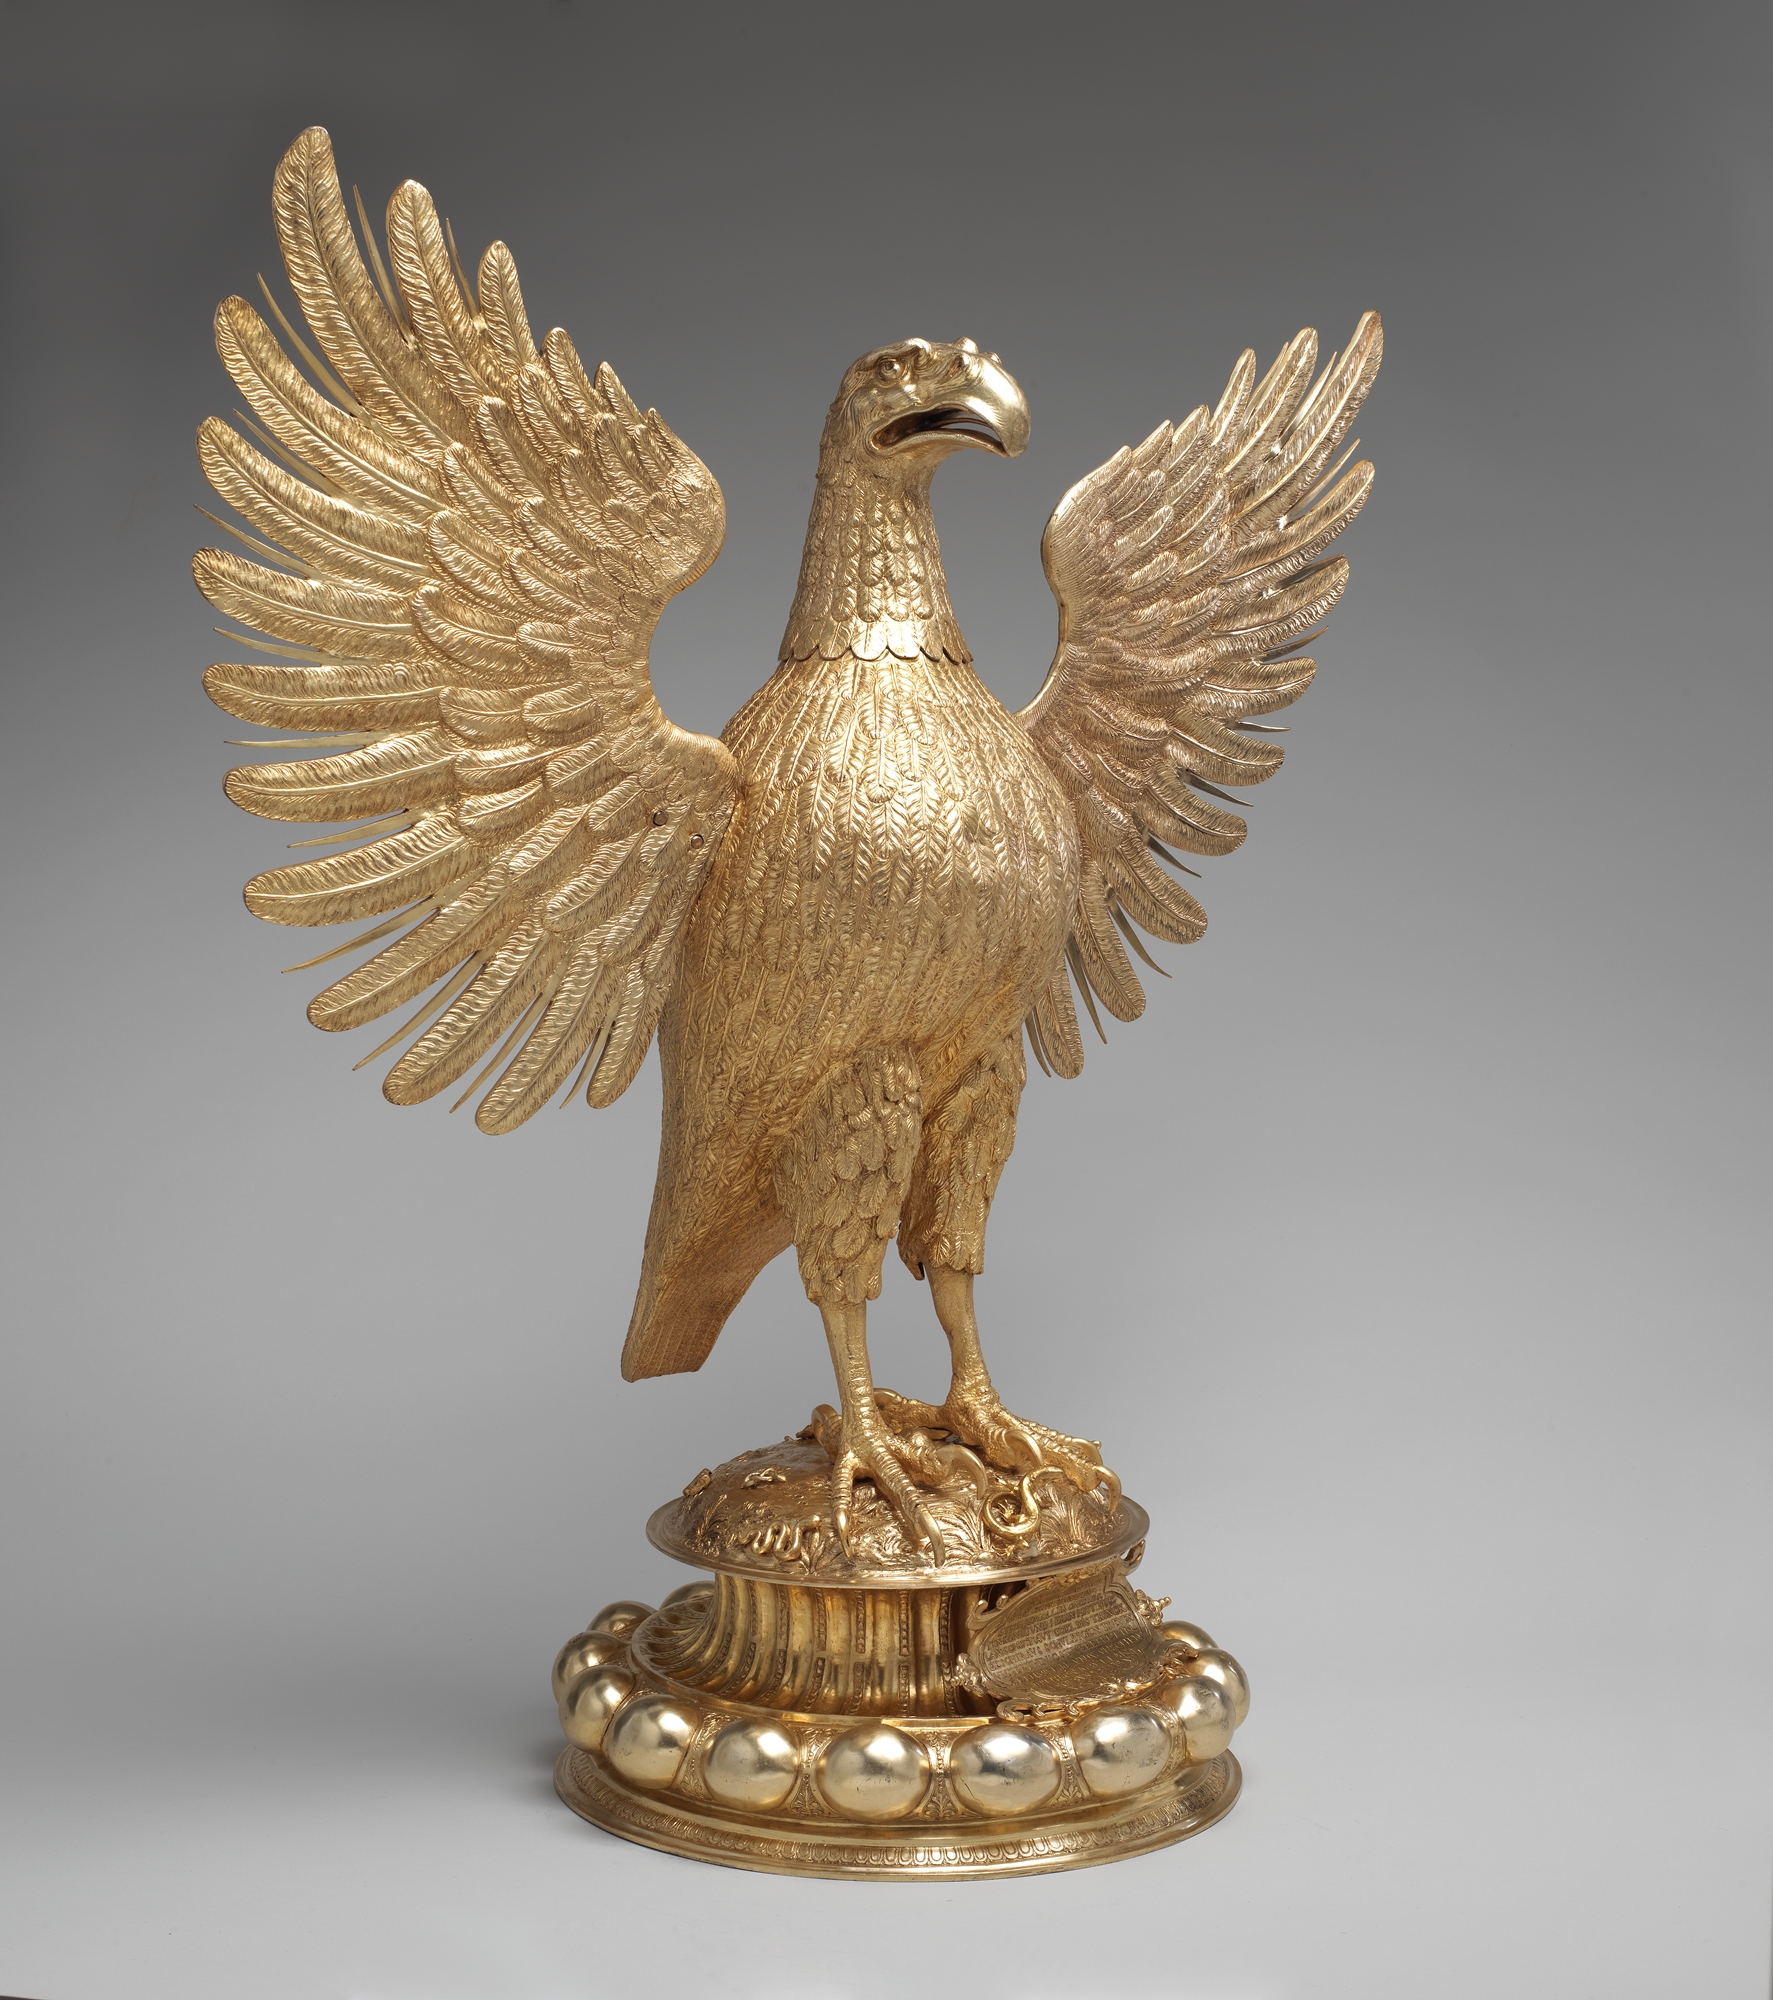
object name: cup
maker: christoph jamnitzer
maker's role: artist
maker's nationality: german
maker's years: 1563-1618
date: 1801-1900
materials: copper, gilt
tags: eagles